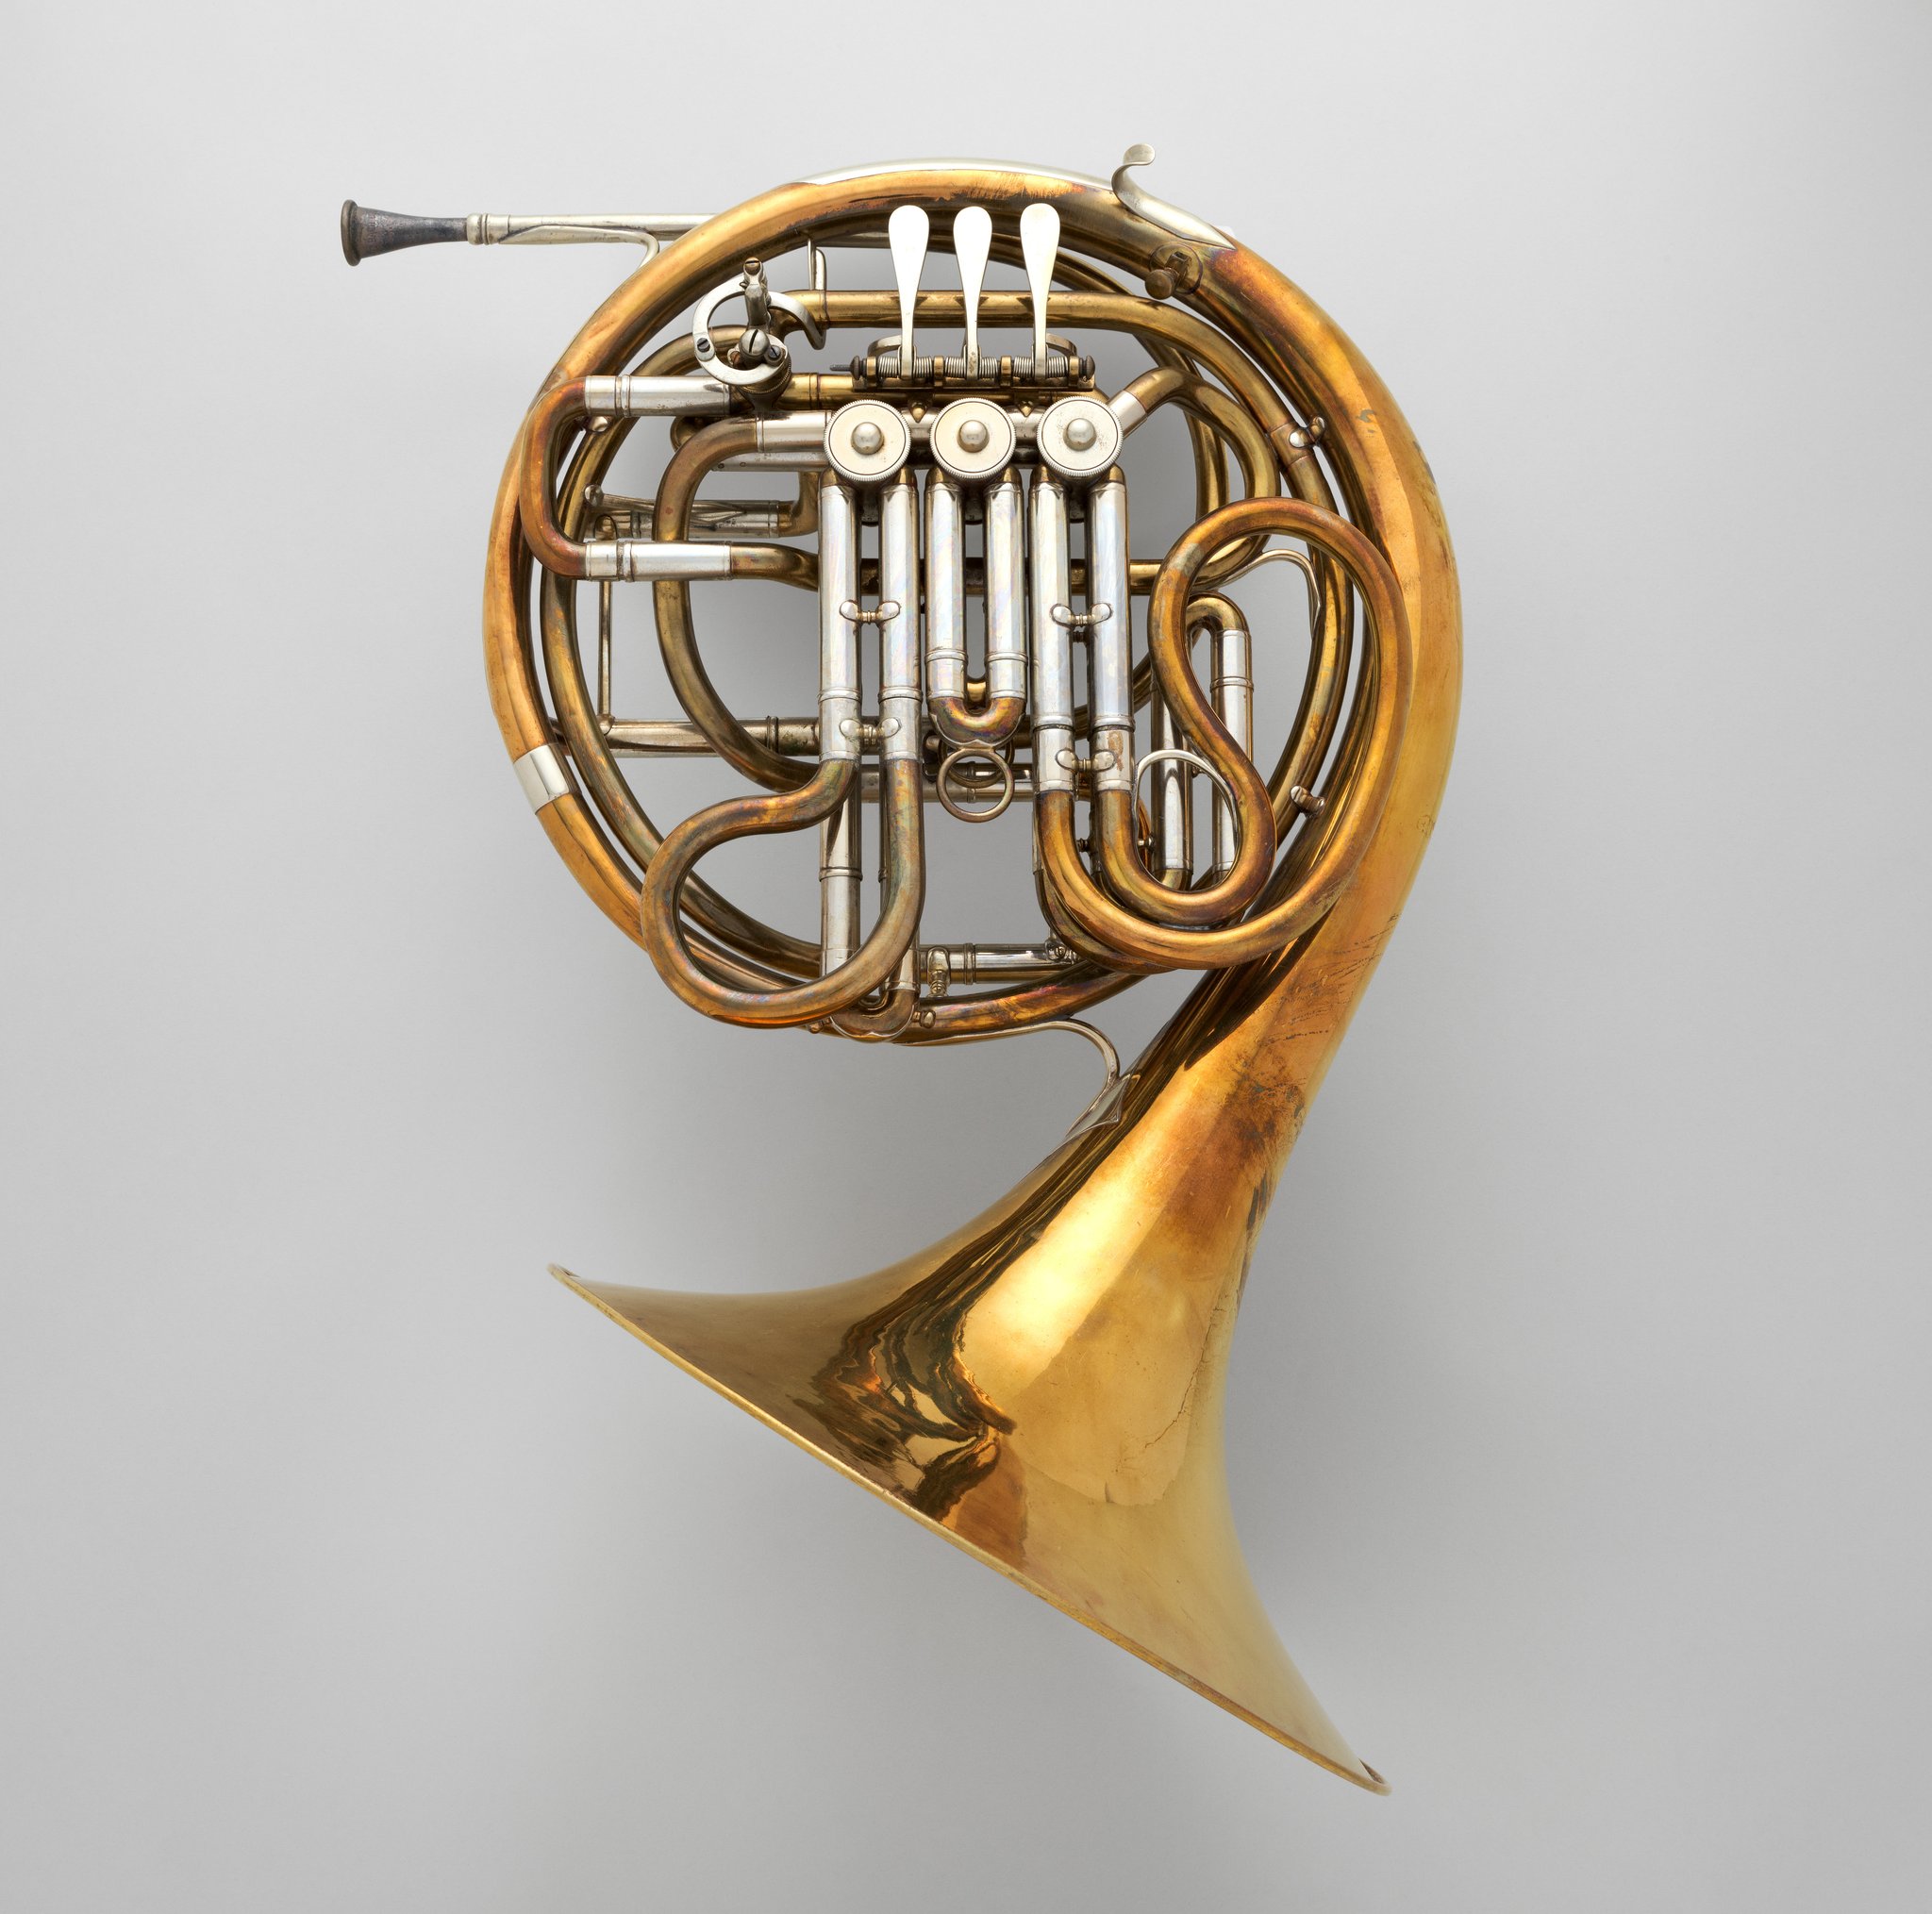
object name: double horn in f b flat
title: Double Horn in F / B-flat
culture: german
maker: eduard kruspe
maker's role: maker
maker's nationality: german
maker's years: 1831-1919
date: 1904-1919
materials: brass, nickel, silver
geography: germany